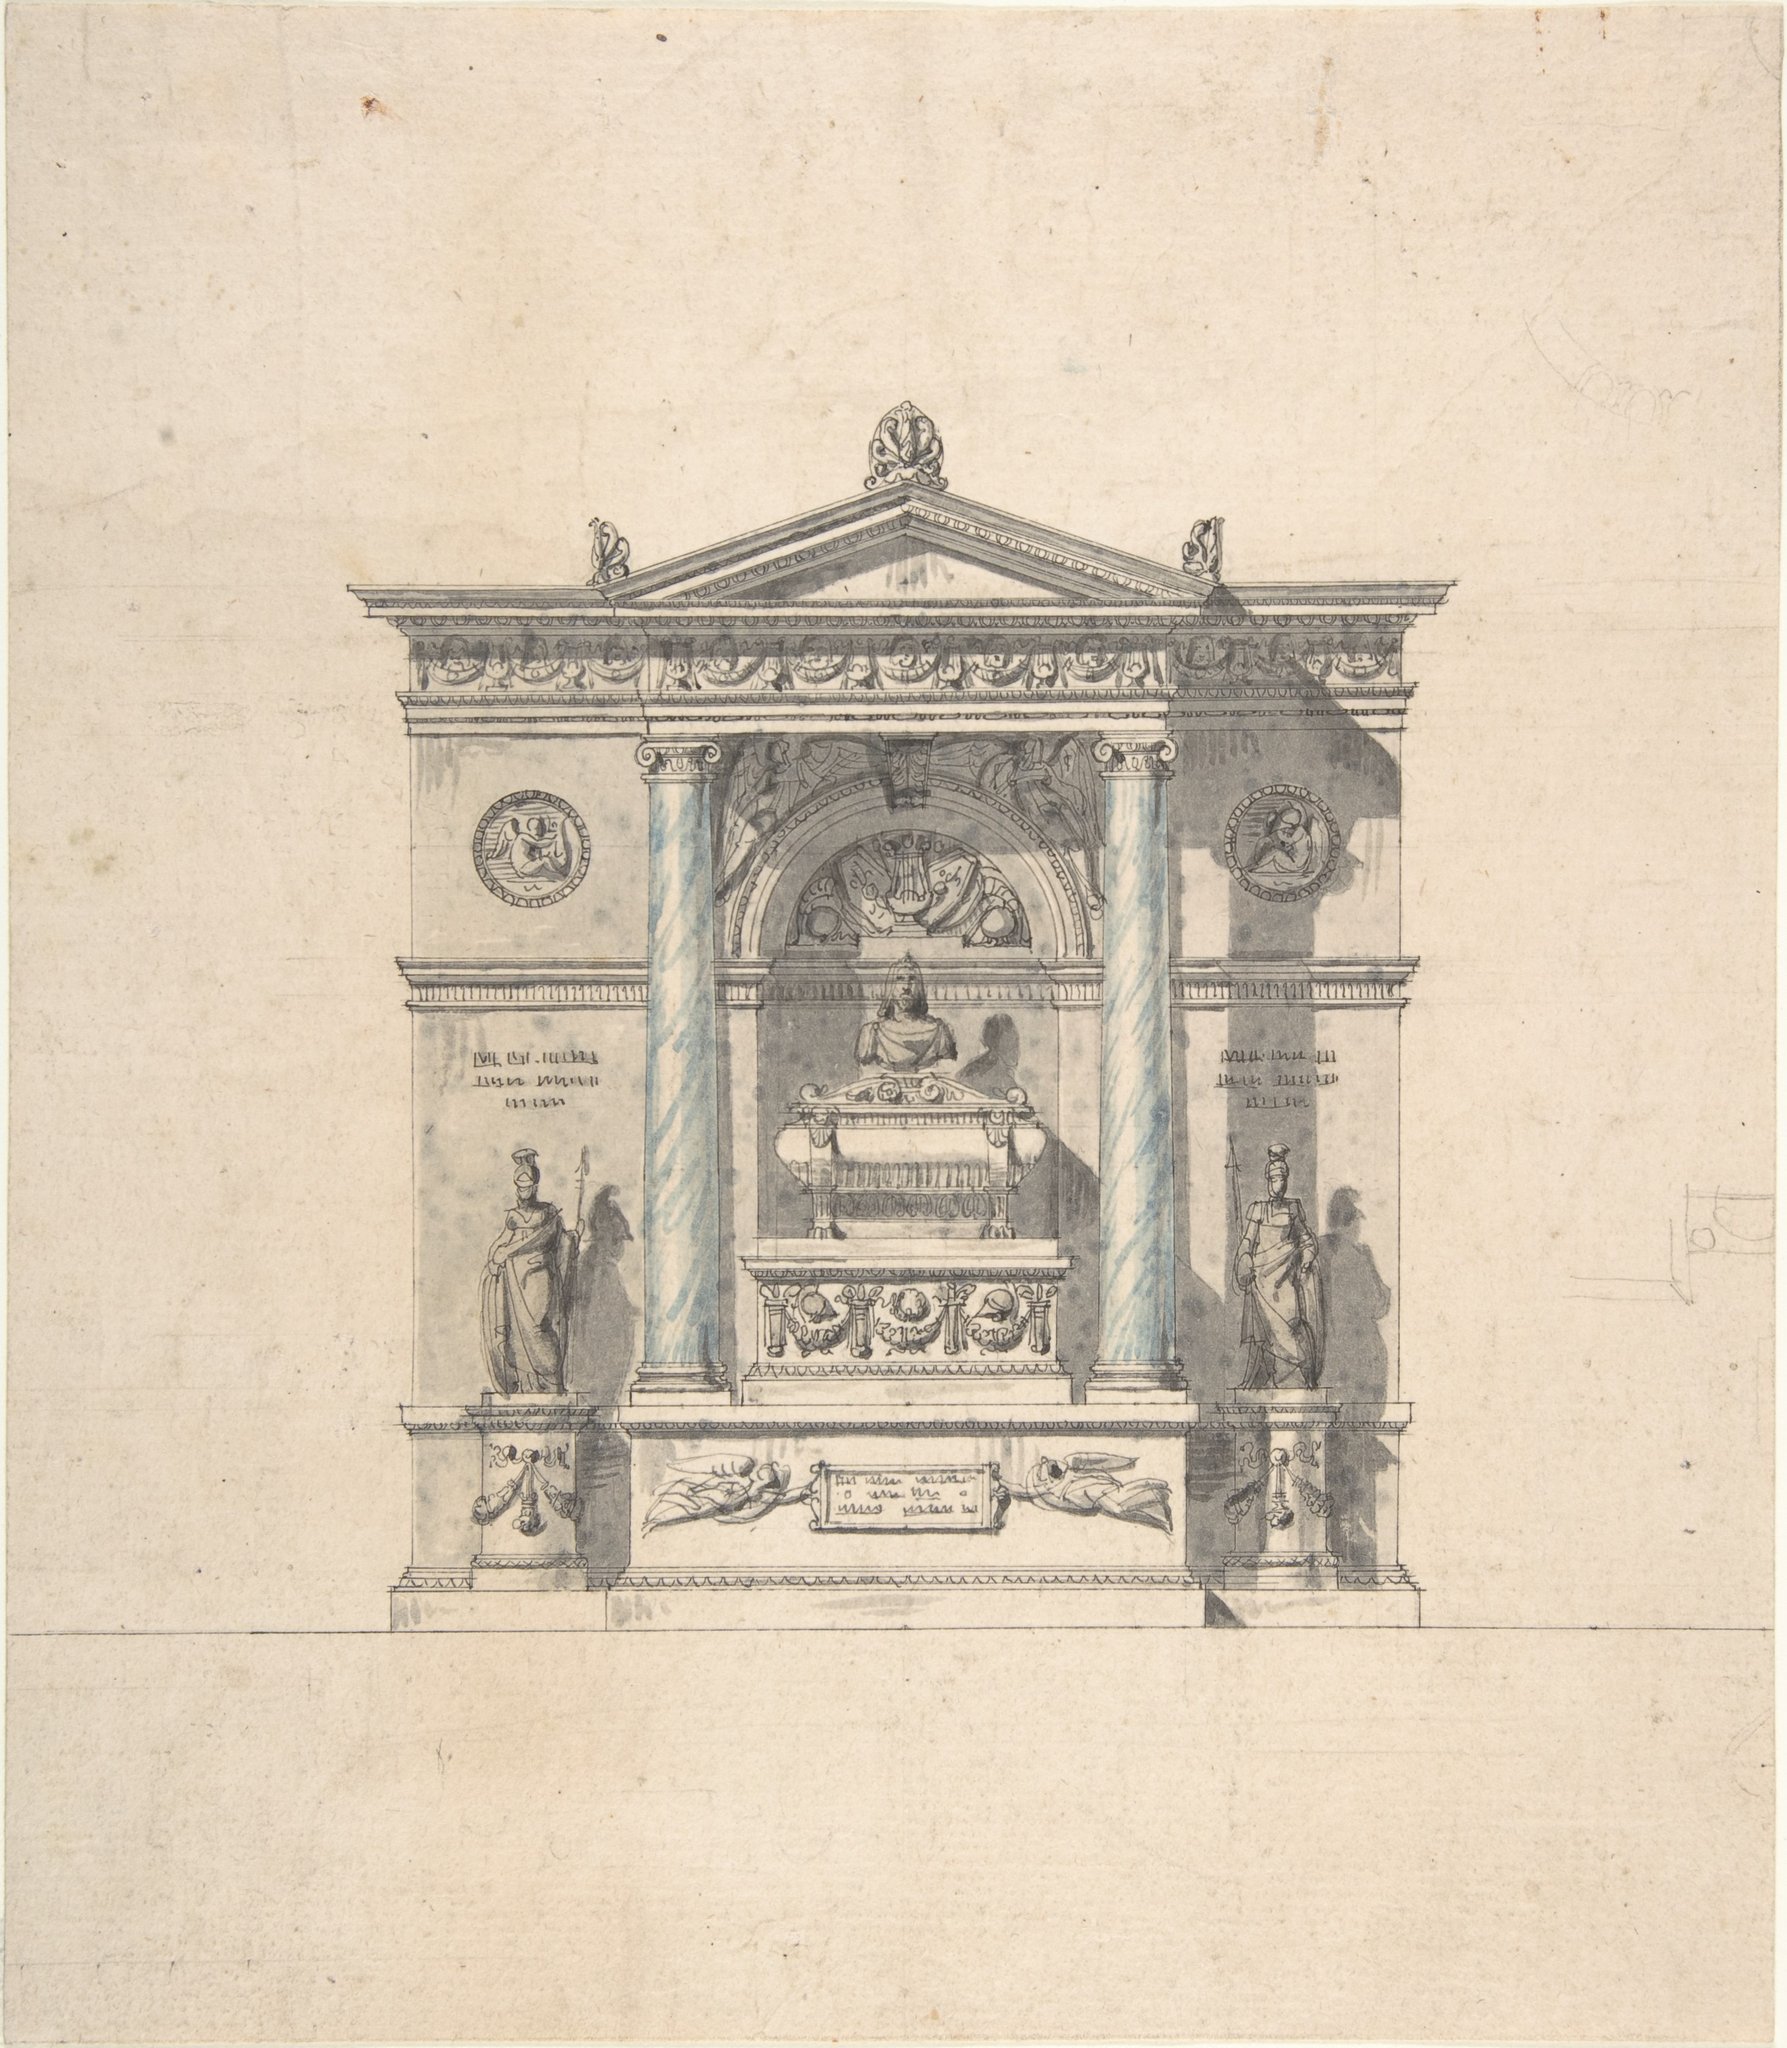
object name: drawing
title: Elevation for a Wall Tomb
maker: jean michel moreau le jeune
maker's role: artist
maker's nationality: french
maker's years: 1741-1814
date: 1741-1814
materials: graphite, ink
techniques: brush, pen, drawing, wash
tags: architecture,tombs